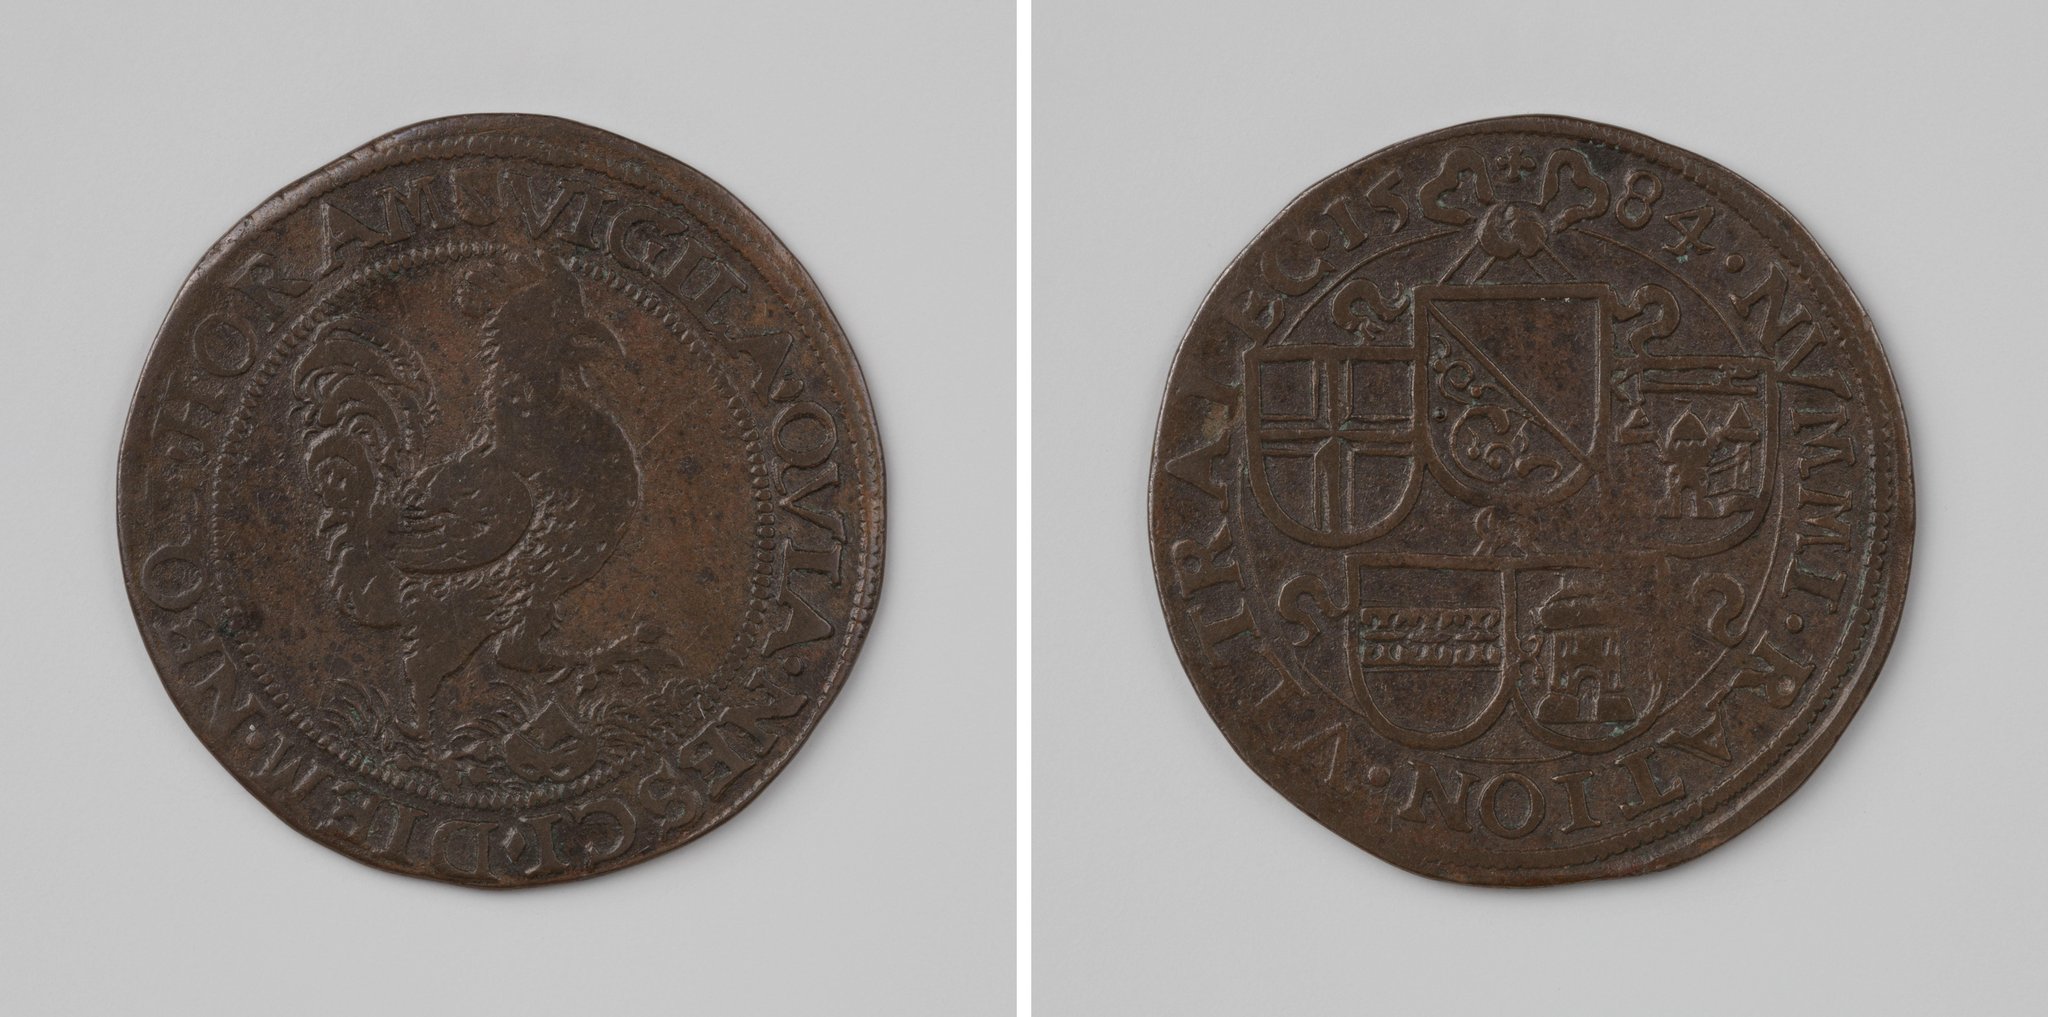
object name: jeton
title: Aansporing tot eensgezindheid in de strijd tegen de Spanjaarden, rekenpenning van de rekenkamer van Utrecht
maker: Anonymous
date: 1584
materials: copper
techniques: striking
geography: netherlands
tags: rhenen, wijk bij duurstede, utrecht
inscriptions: circumscription: ‘NVMMI RATION VLTRAIEC 1584’, circumscription: ‘VIGILA QVIA NESCI DIEM NEQ HORAM’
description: Koperen penning. Voorzijde: haan, die wacht houdt bij diamant binnen omschrift. Keerzijde: met lint samengebonden wapenschilden van Utrecht, Amersfoort, Rhenen, Wijk bij Duurstede en Montfoort binnen omschrift.